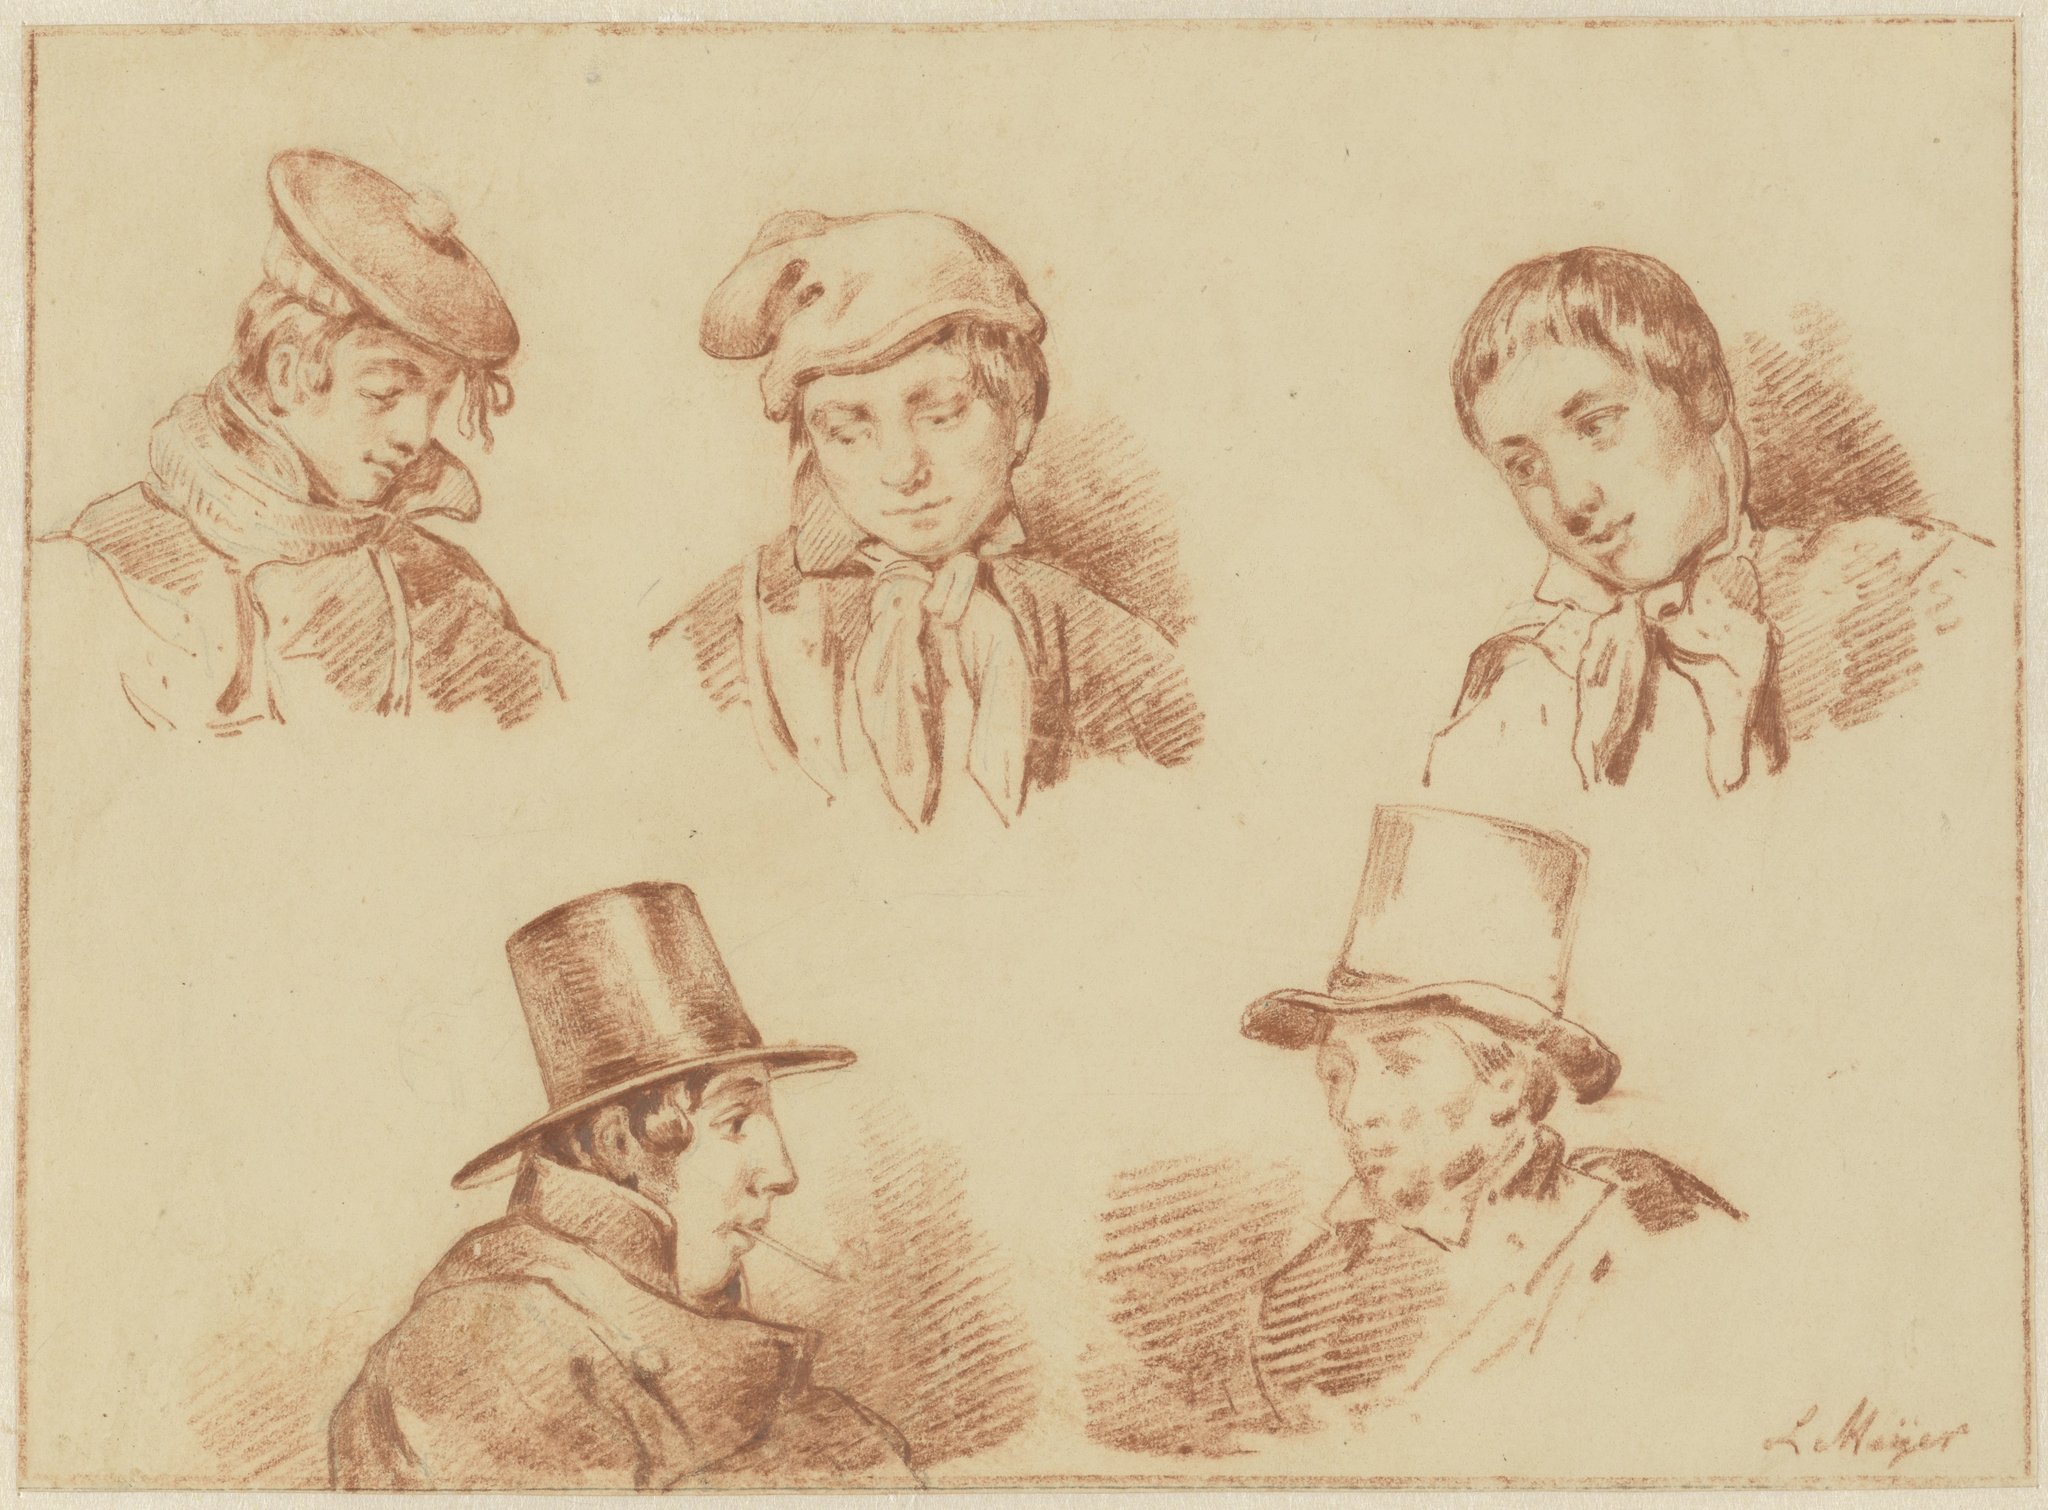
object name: drawing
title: Studieblad met vijf jongens- en mannenhoofden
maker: louis meijer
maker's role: draughtsman, painter, print maker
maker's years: 1809-1866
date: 1819-1866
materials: chalk, paper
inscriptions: signature: ‘L. Meijer’